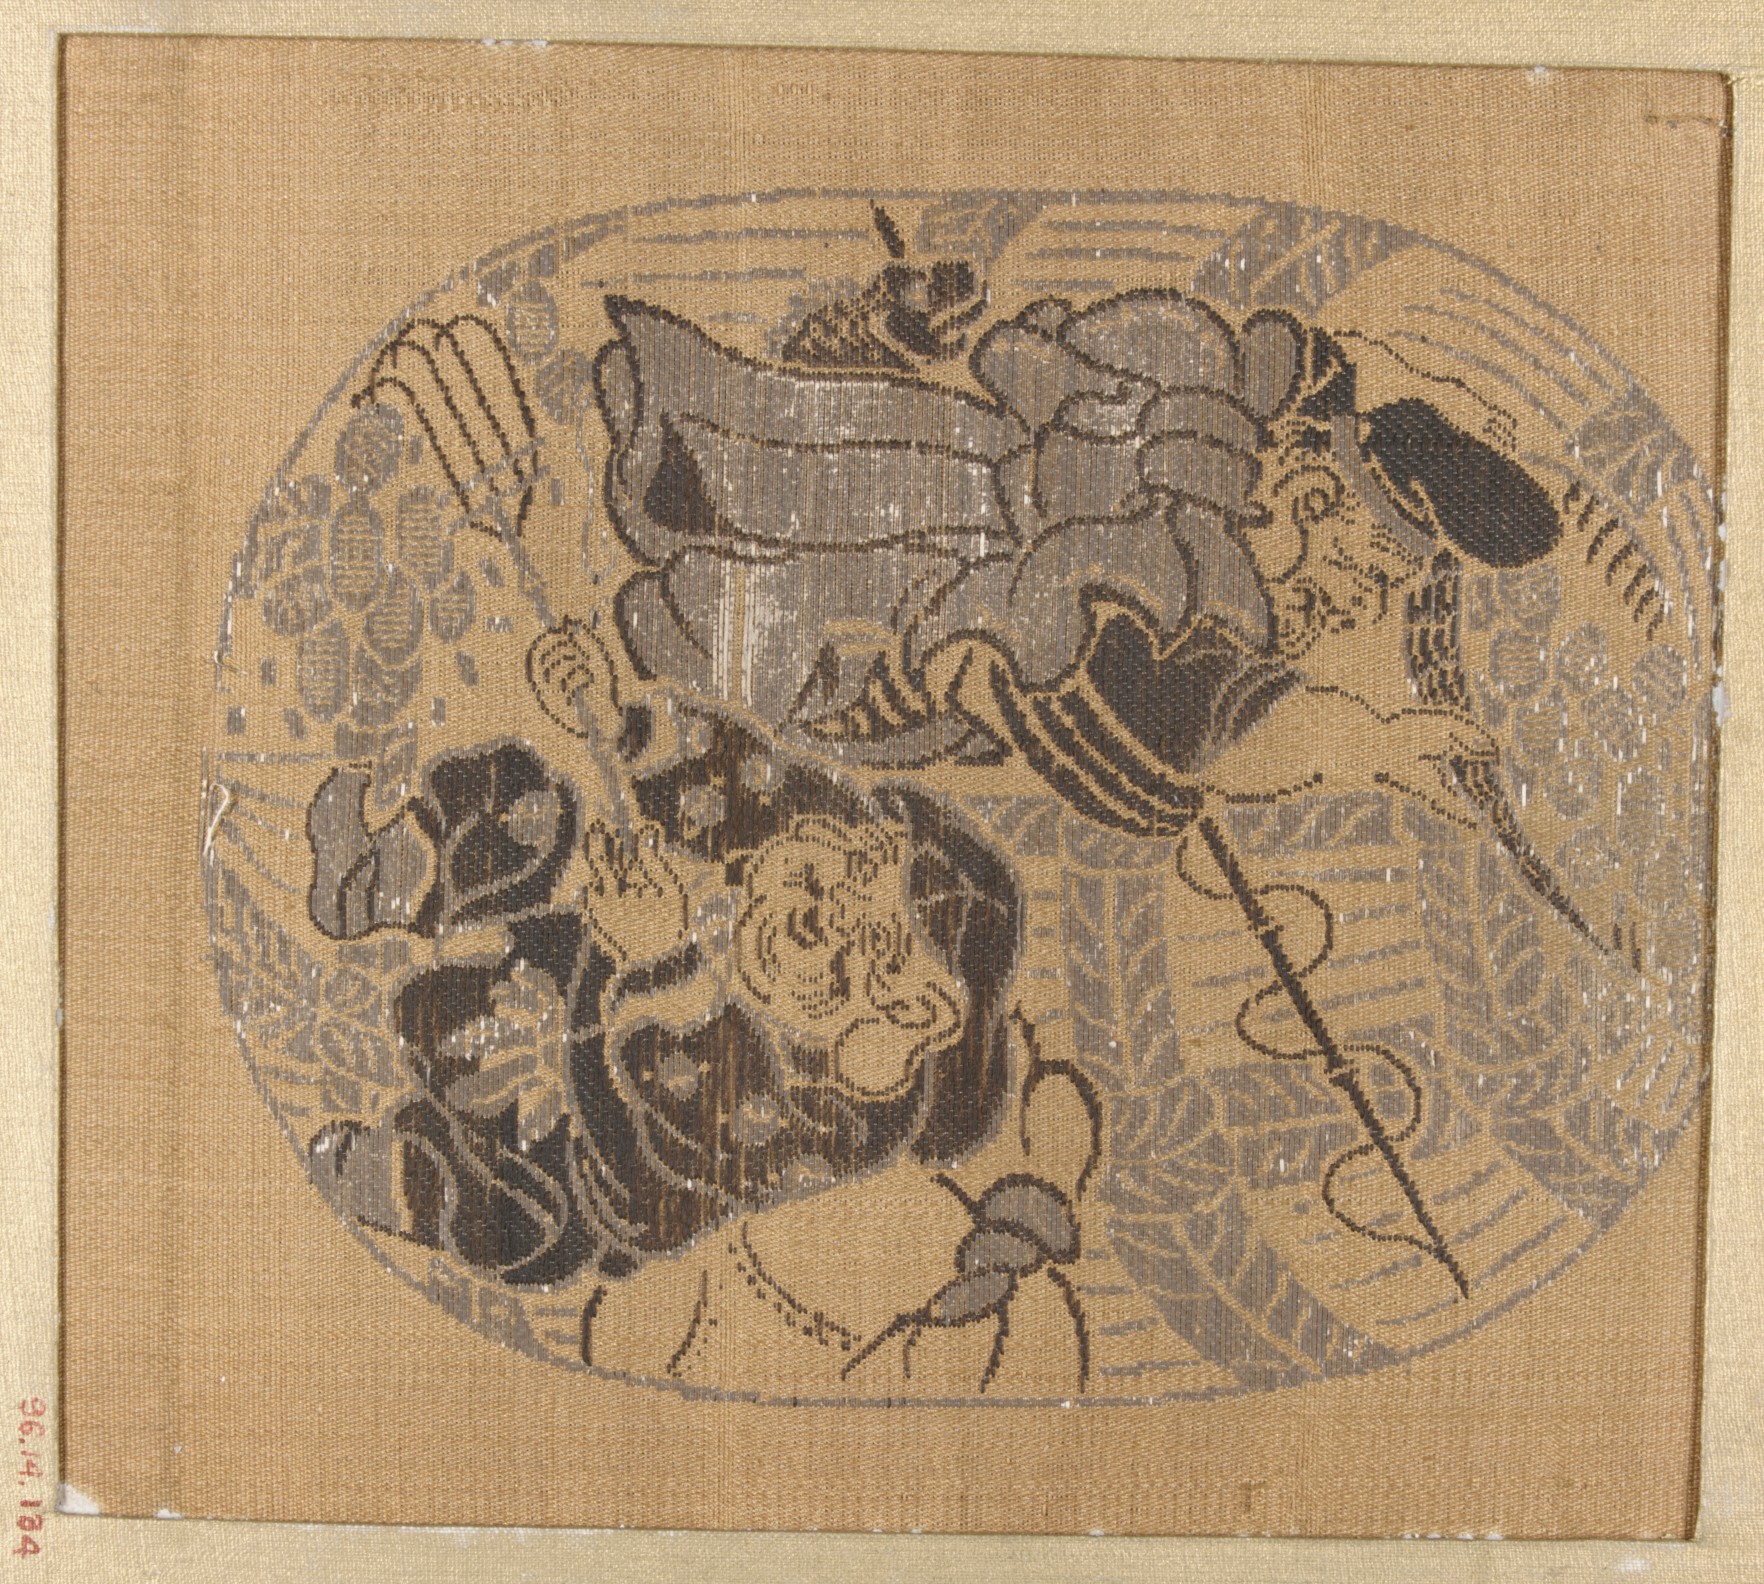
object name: piece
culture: japanese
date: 1701-1900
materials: silk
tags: men,fishing